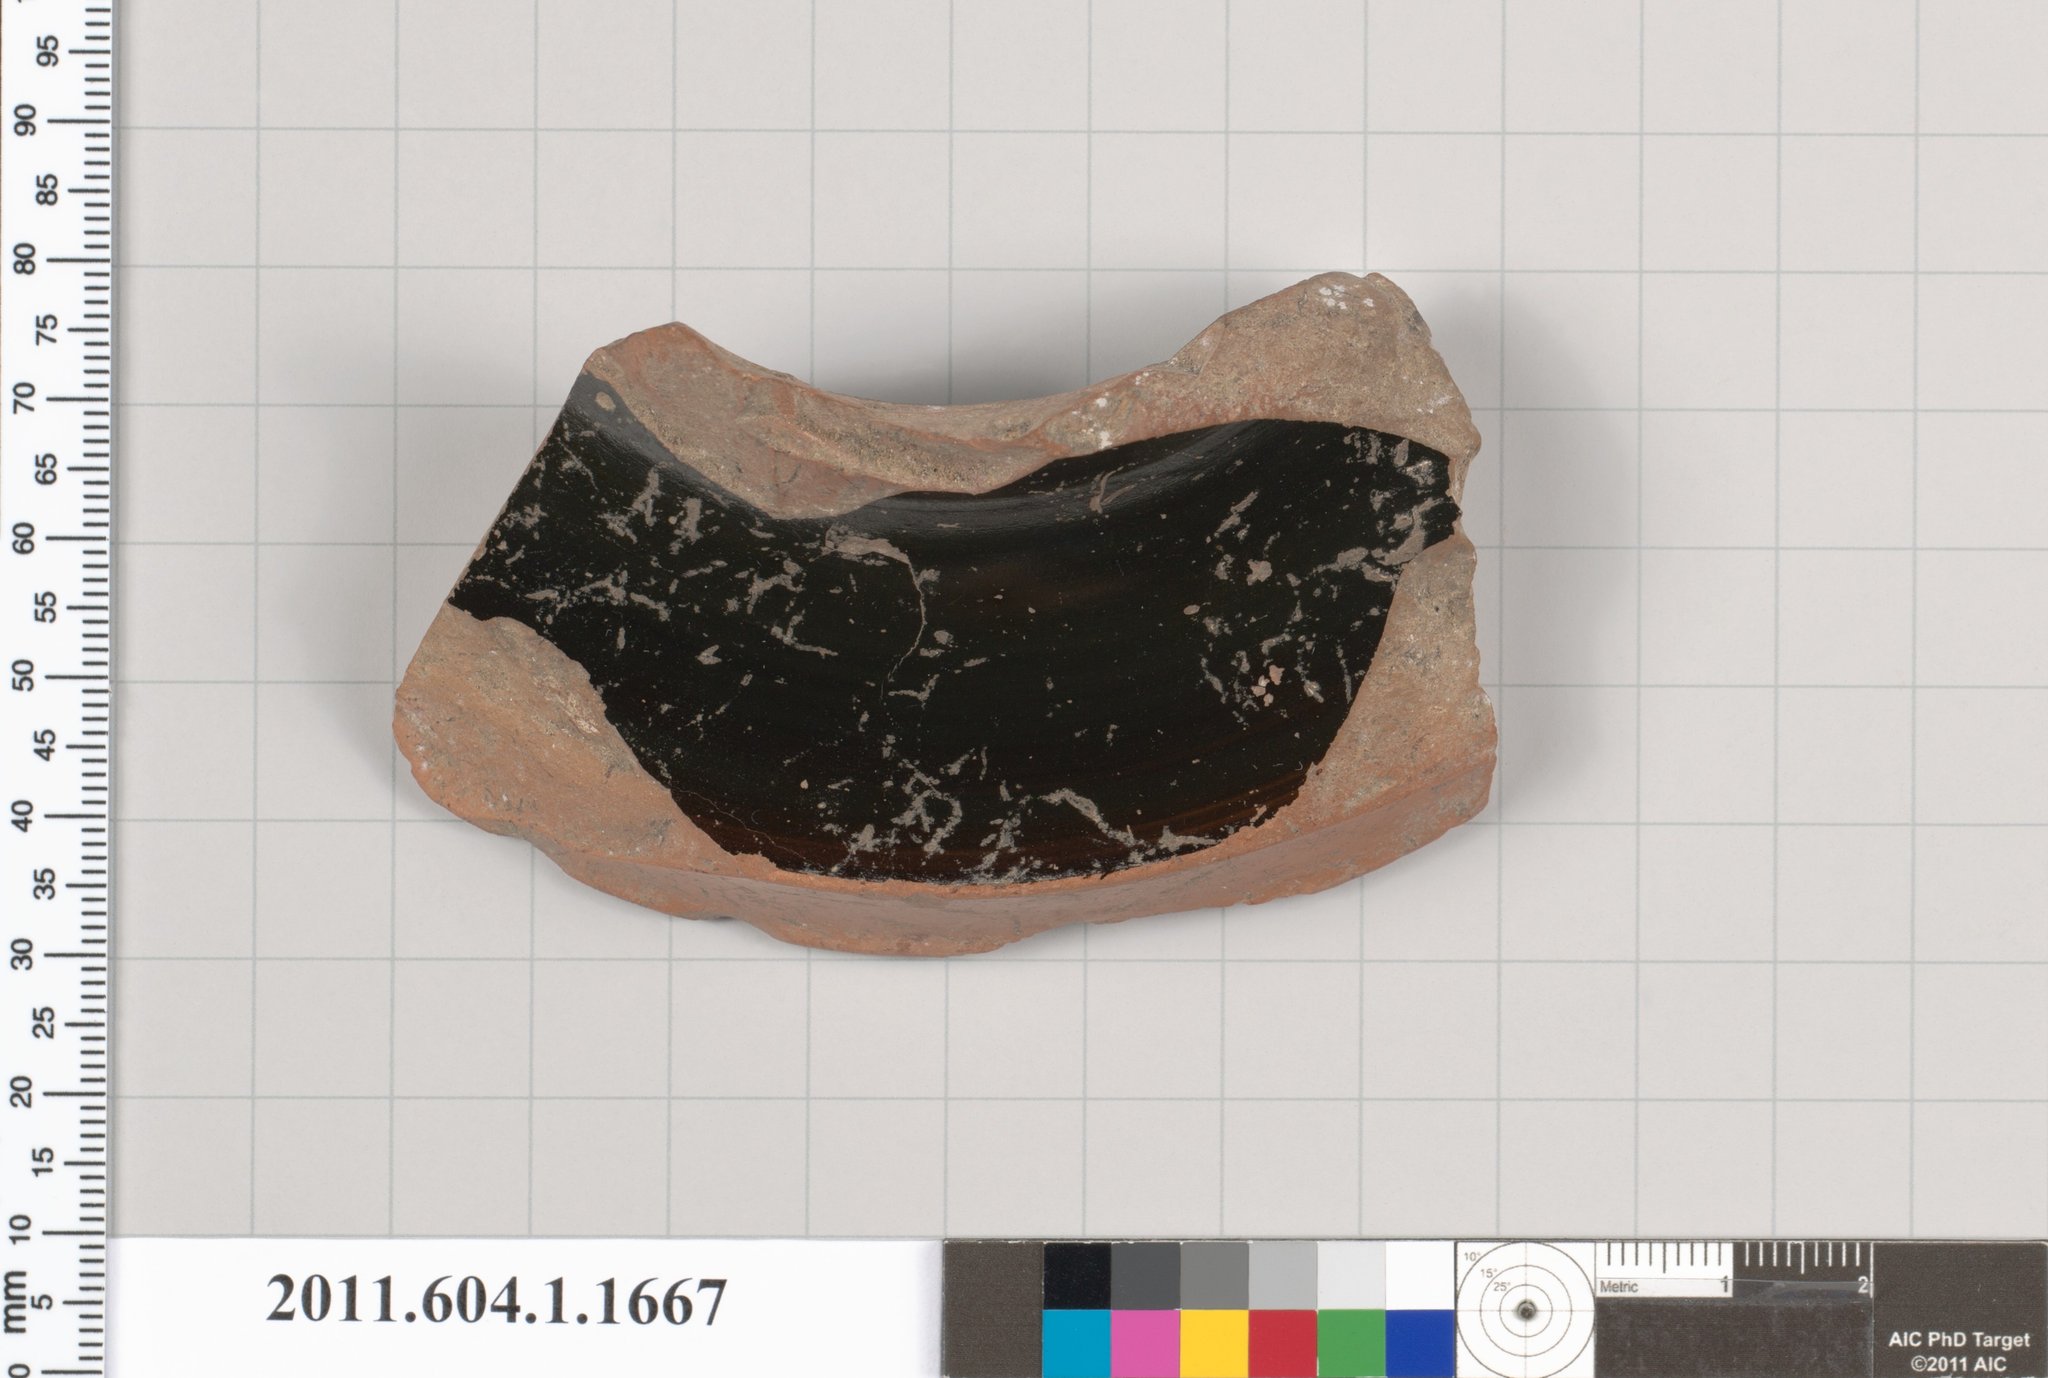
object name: kylix fragment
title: Terracotta fragment of a kylix (drinking cup)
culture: greek, attic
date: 534-468 BCE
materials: terracotta